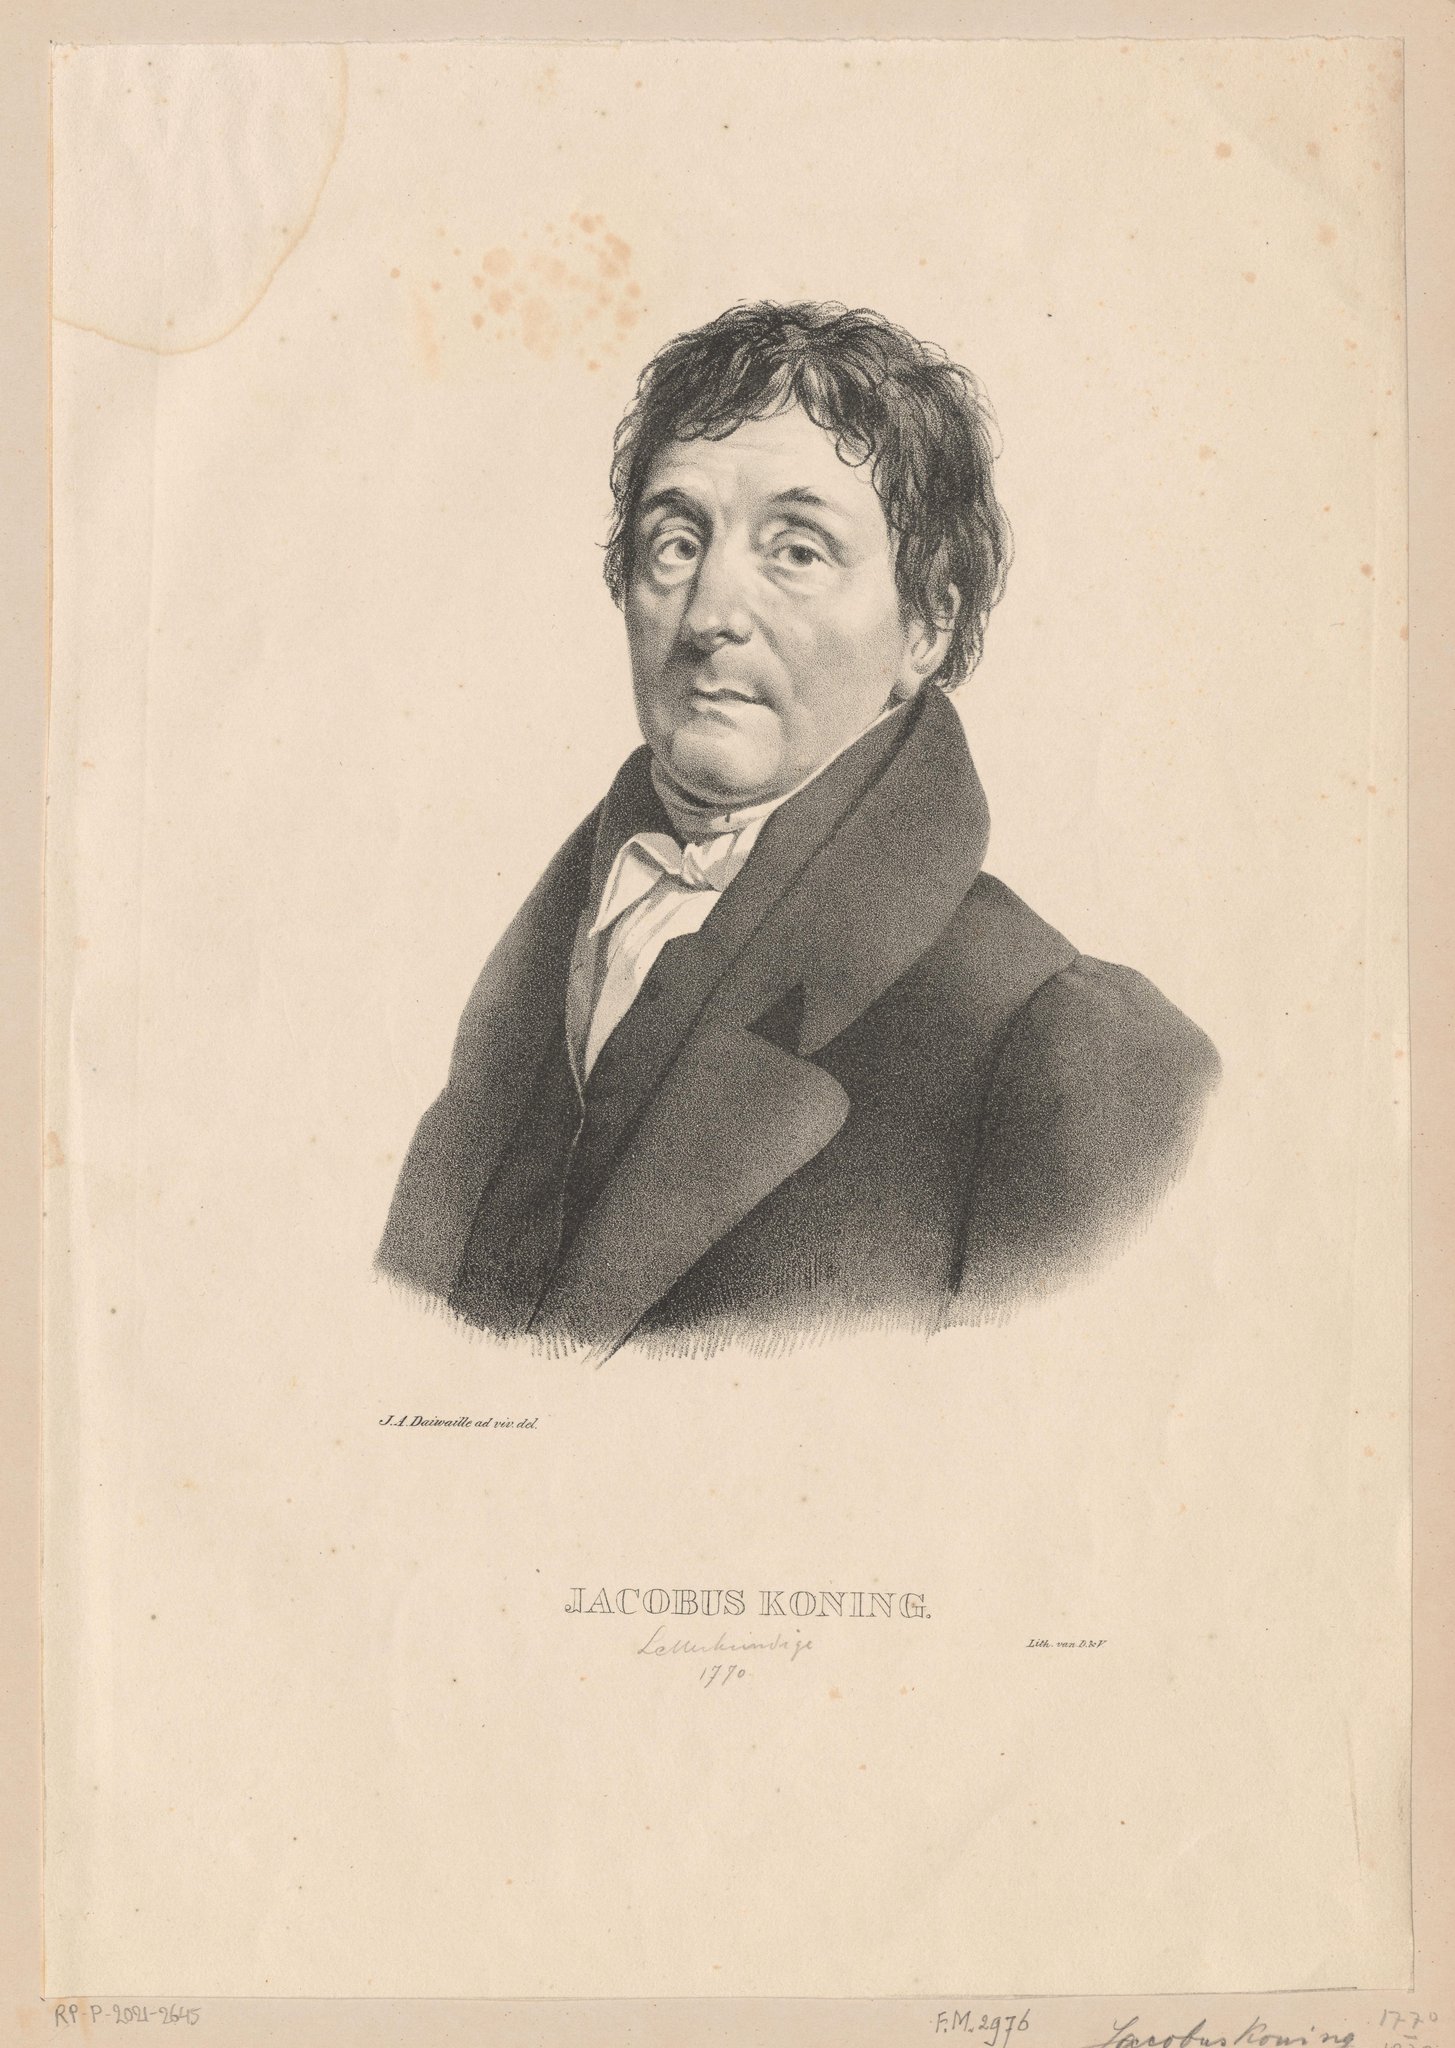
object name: print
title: Portret van Jacobus Koning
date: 1820-1853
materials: paper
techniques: lithograph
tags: amsterdam, jacobus koning, historical persons, king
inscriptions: signature: ‘Lith. van D.& V.’